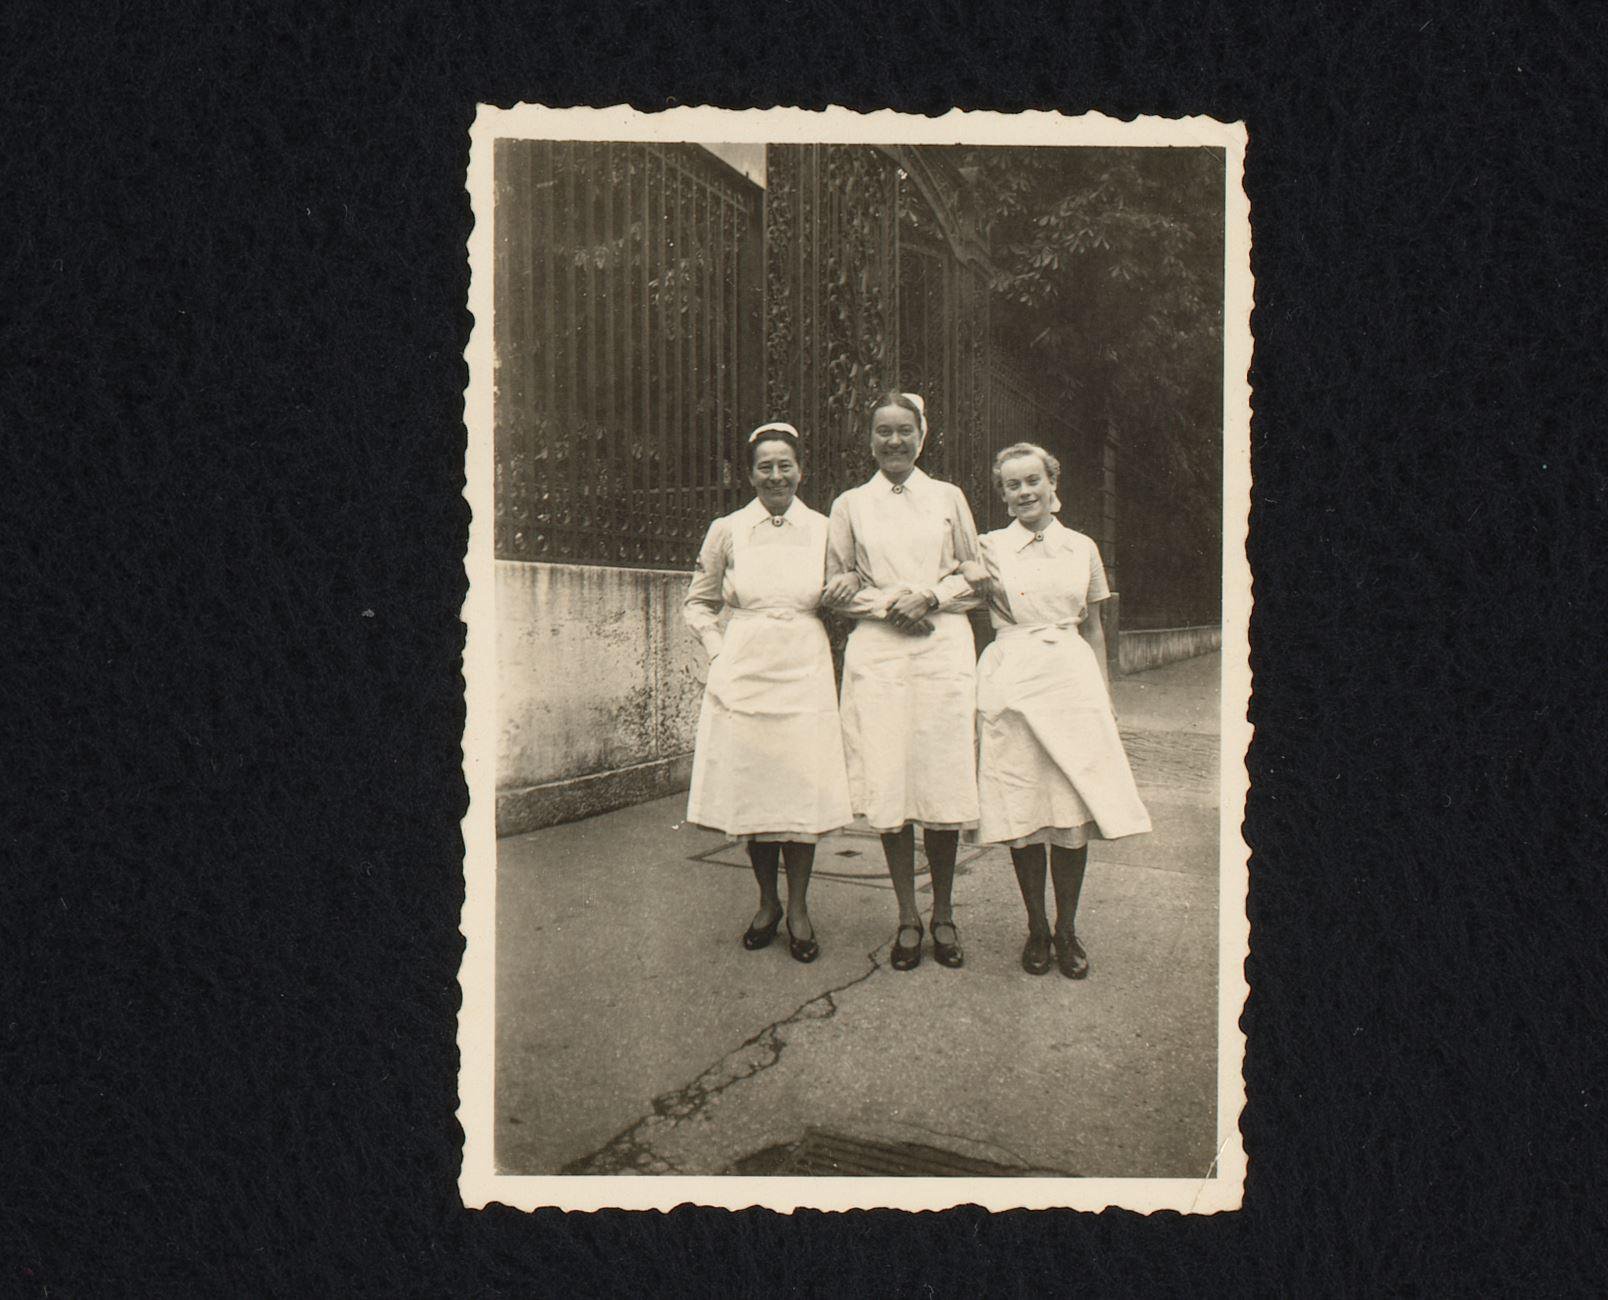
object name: photograph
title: Drie verpleegsters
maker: Anonymous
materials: photographic support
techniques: gelatin silver print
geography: paris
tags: nurse ~ hospital, paris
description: Drie verpleegsters in uniform, aan de linkerzijde een hek. In Parijs begin mei 1943. Onderdeel van de groep losse foto's behorend bij het fotoalbum over de Kriegsmarine 1940-1943.